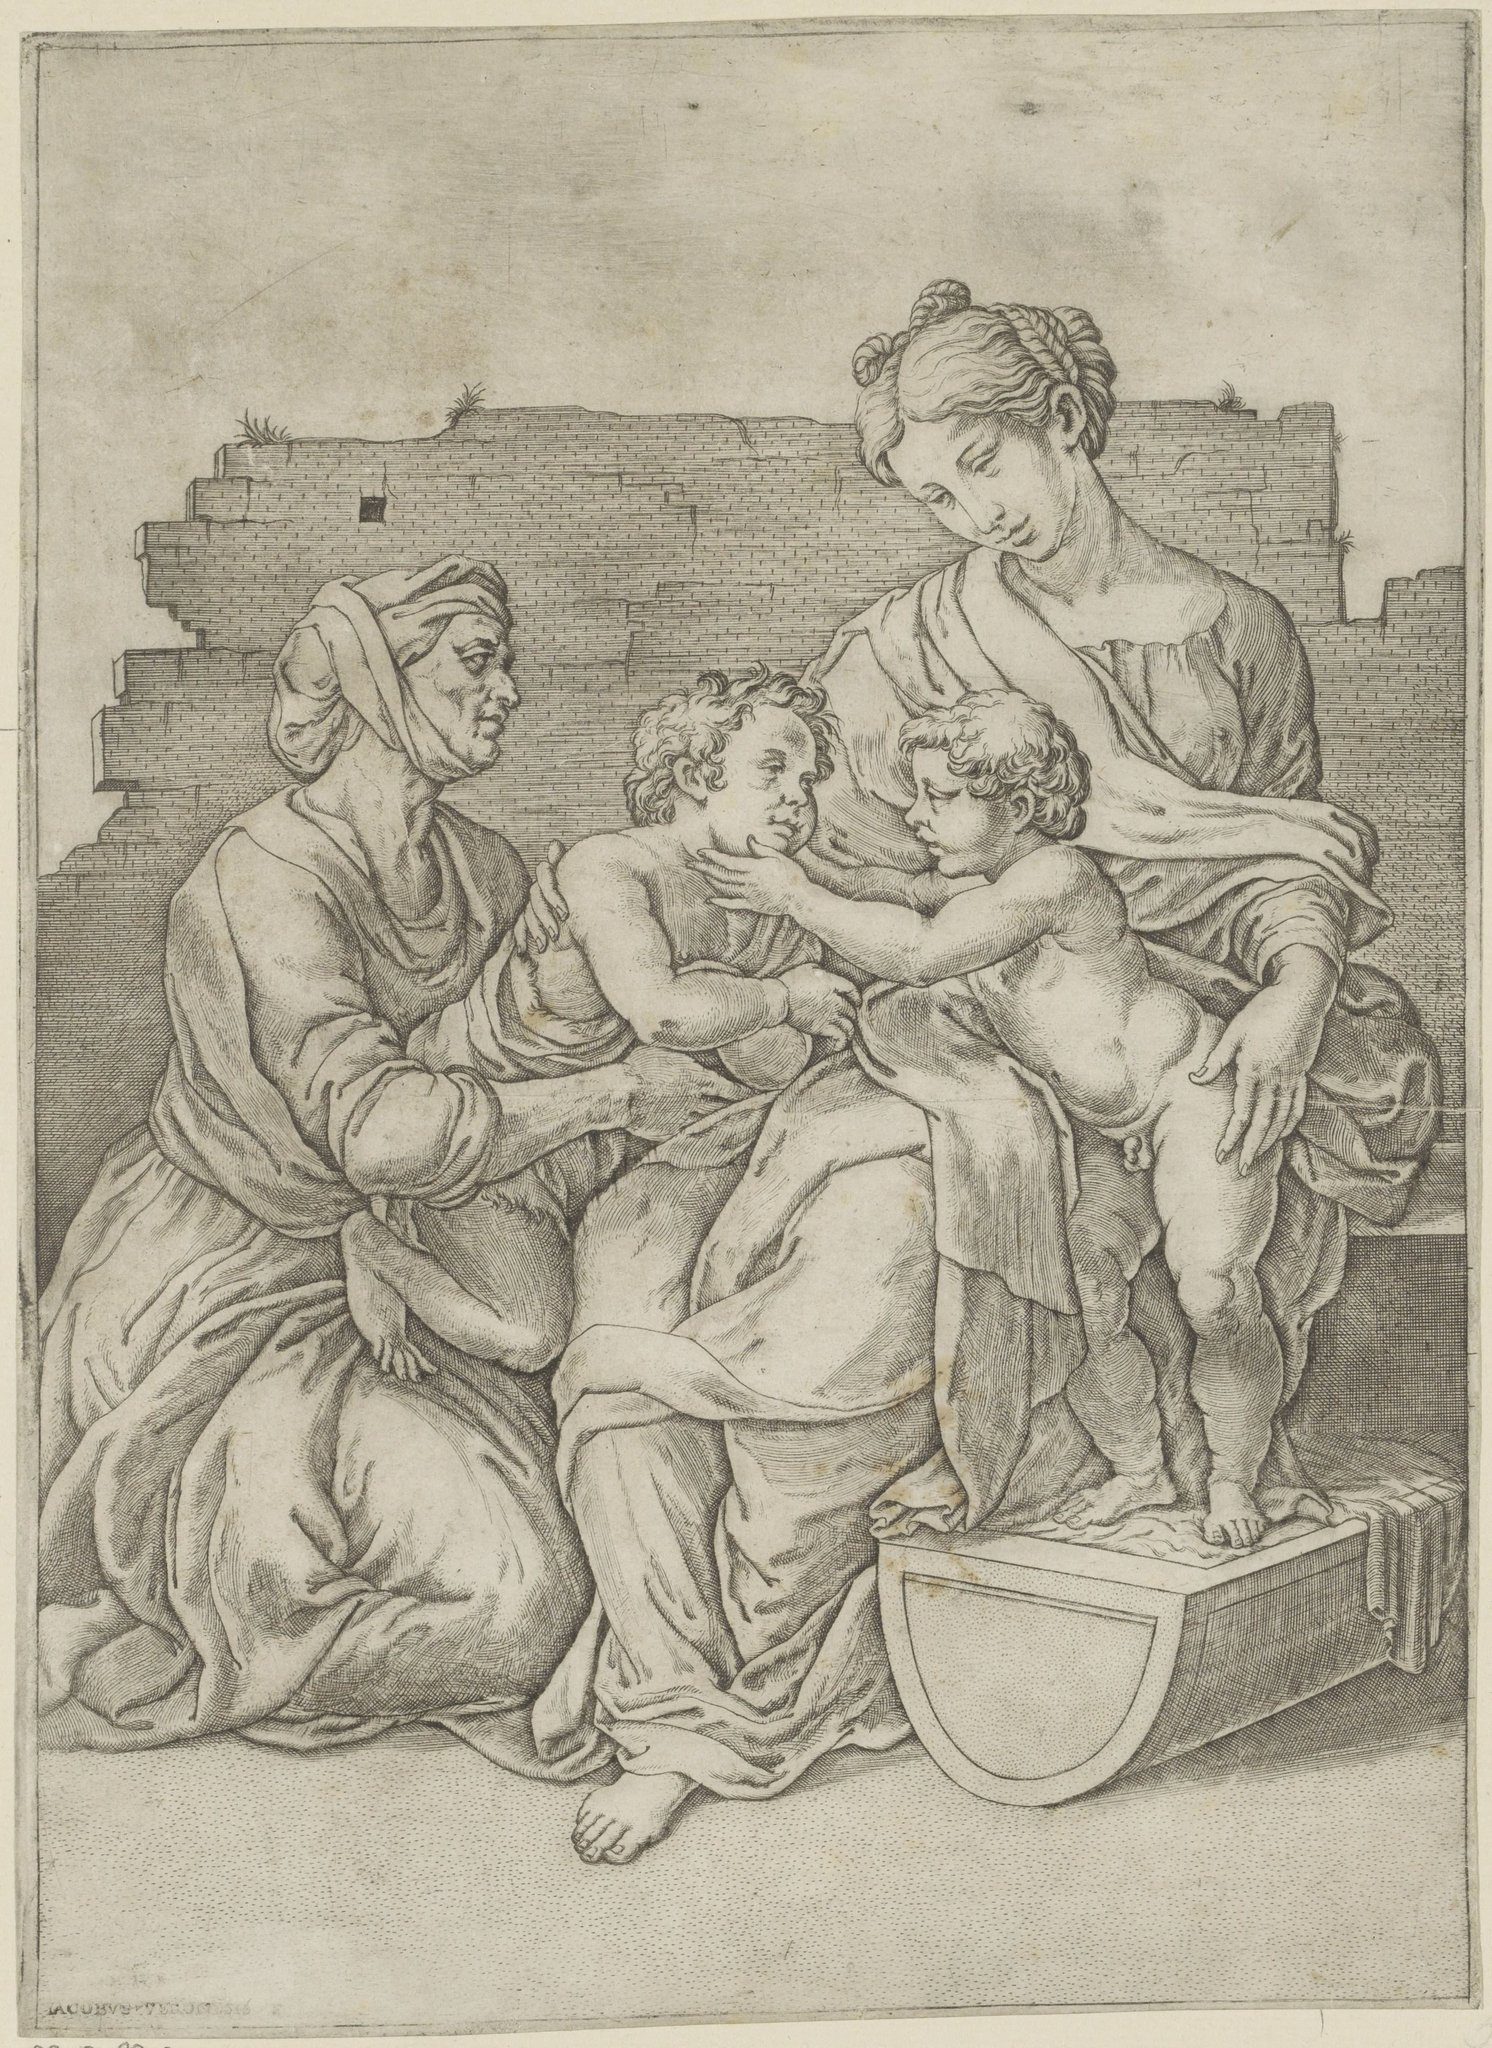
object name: print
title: Maria met Kind, de H. Elisabet en de jonge Johannes de Doper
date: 1515-1565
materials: paper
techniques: engraving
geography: italy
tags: mary, the christ-child and john the baptist, elisabeth present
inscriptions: collector's mark: Lugt 240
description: Maria, het Chistuskind, Elisabet en de jonge Johannes de Doper zitten voor een stenen muur. Christus heeft het gezicht van Johannes in zijn handen